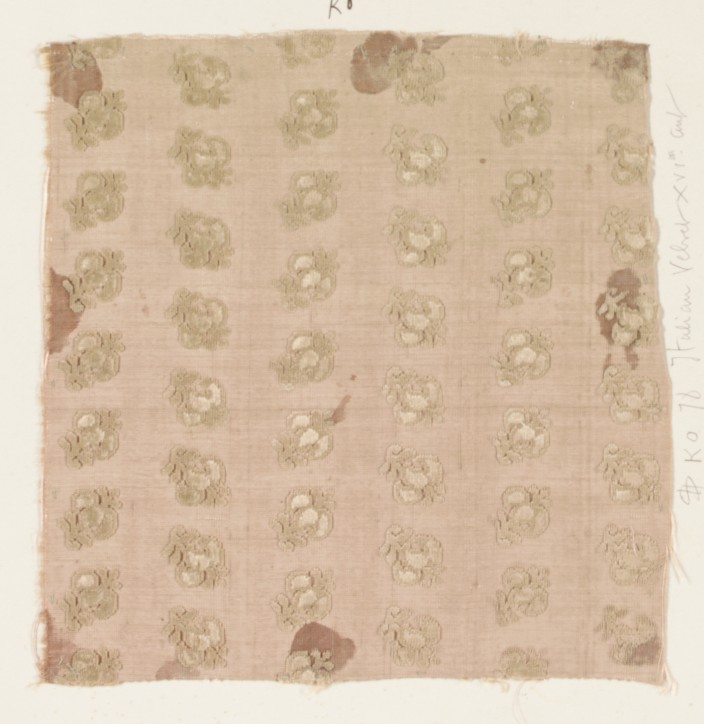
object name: fragment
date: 1501-1600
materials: silk